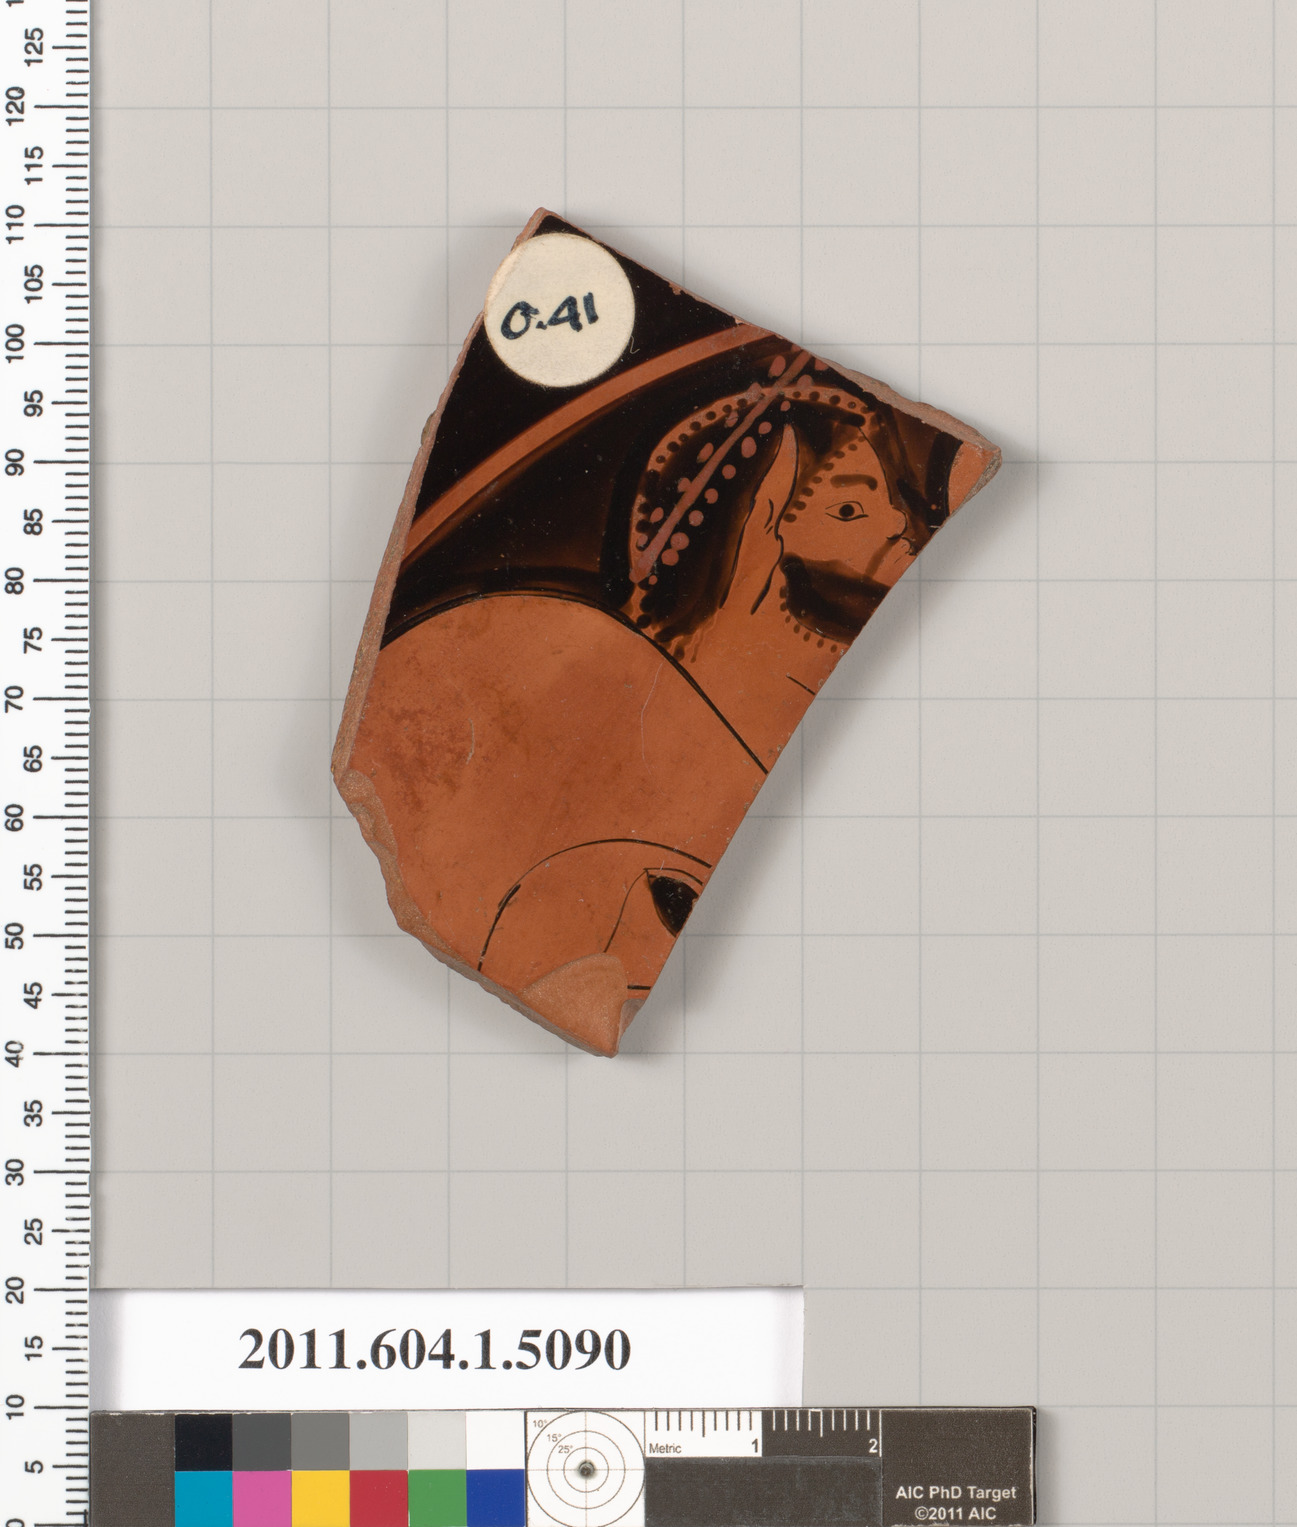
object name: kylix fragment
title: Terracotta fragment of a kylix (drinking cup)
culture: greek, attic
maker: nikosthenes painter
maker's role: artist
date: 534-501 BCE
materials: terracotta